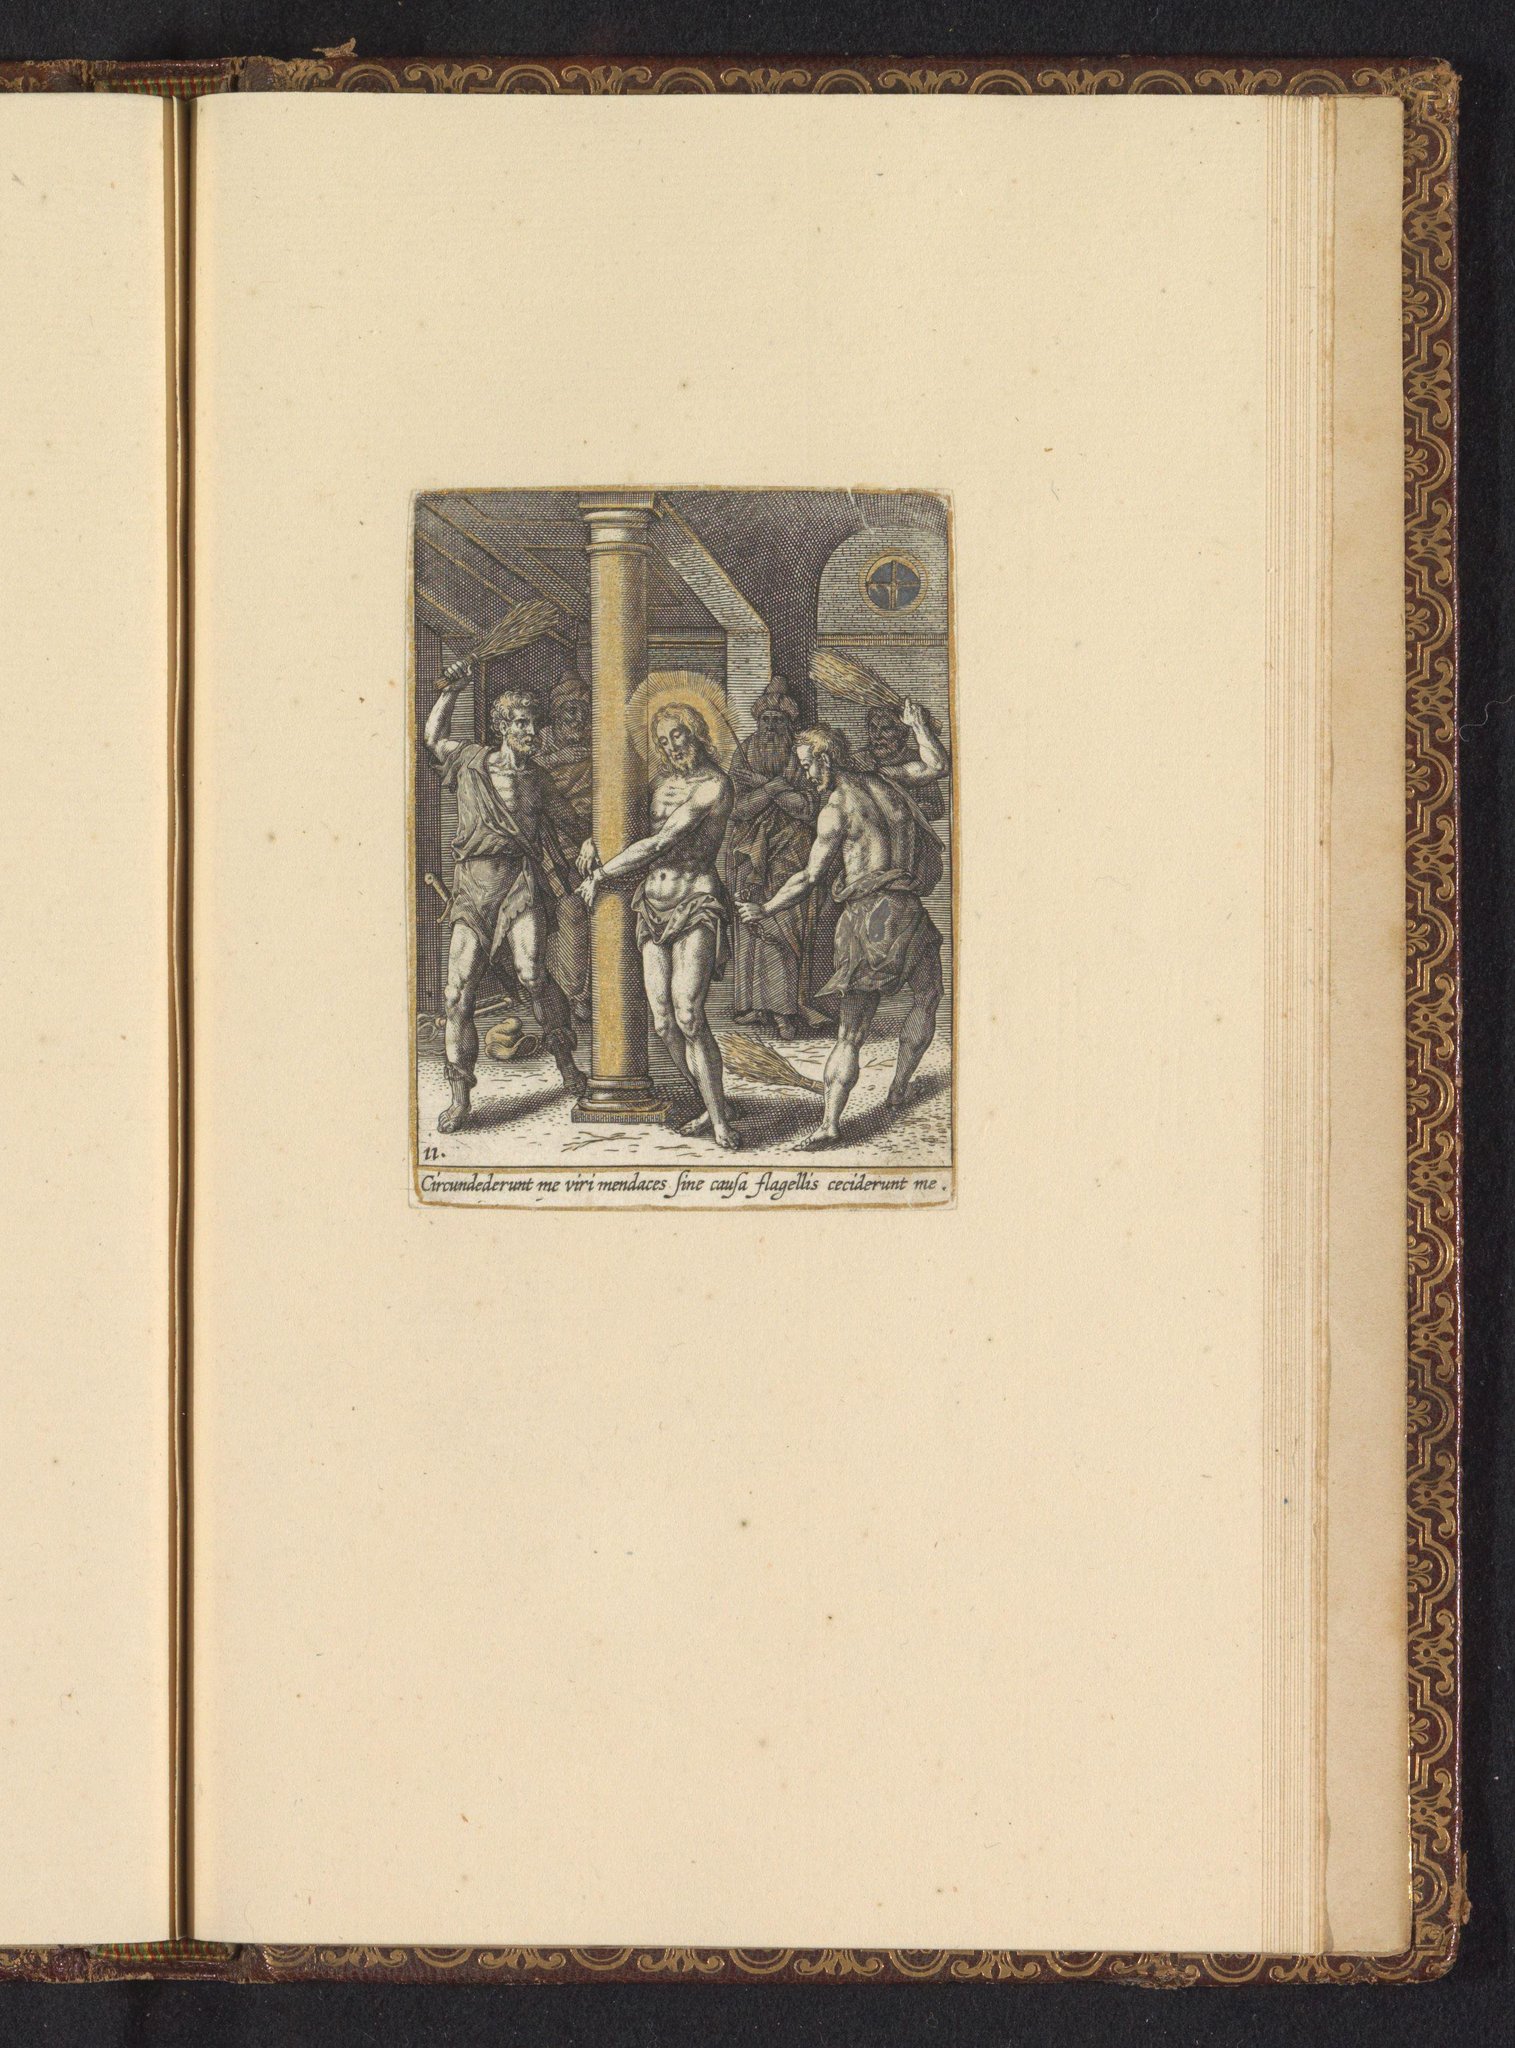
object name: print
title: Passio et resurrectio D.N. Iesu Christi. Edita et excusa ab Ad. Collaert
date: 1580-1590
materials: gold, paper, silver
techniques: engraving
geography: antwerp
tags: flagellation by soldiers, christ usually tied to a column (matthew 27:26; mark 15:15; john 19:1)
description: Geseling van Christus. Onderdeel van de prentserie over de passie van Christus: Passio et resurrectio D.N. Iesu Christi. Edita et excusa ab Ad. Collaert. In prentalbum met twee reeksen van respectievelijk 34 en 24 gravures met scènes uit het leven en het lijdensverhaal van Christus.